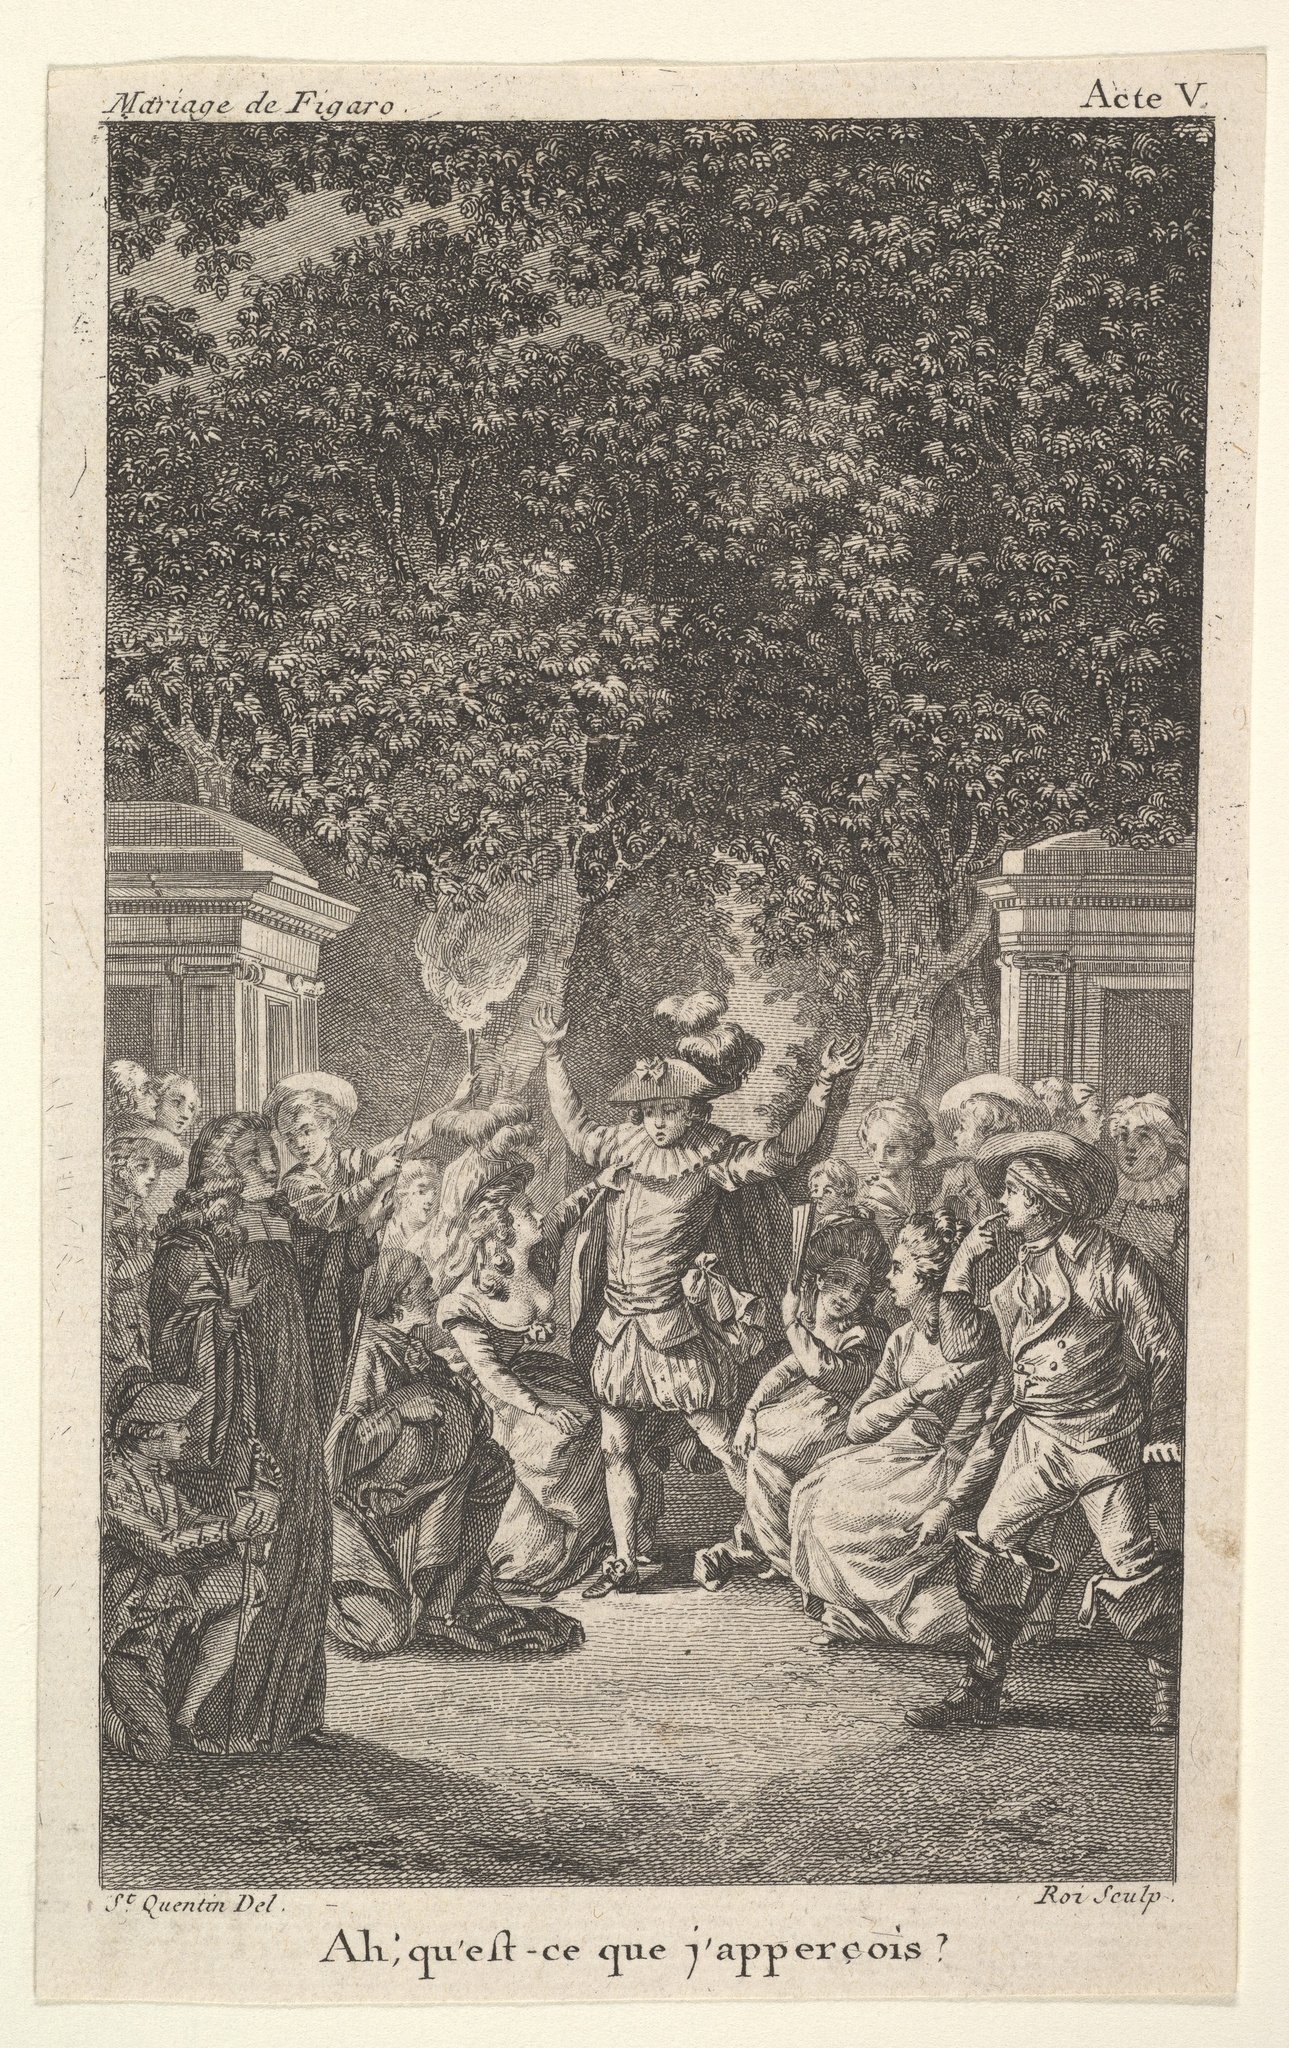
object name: print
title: A young boy holds a torch under trees in a garden, at center a man raises both arms, surrounded by male and female figures, from a series of five illustrations after Jacques Philippe Joseph de Saint-Quentin for 'The mad day, or the marriage of Figaro' (La Folle journée, ou le mariage de Figaro) by Pierre Augustin Caron de Beaumarchais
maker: jacques philippe joseph de saint quentin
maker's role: artist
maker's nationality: french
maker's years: 1738-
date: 1784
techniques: engraving, etching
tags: gardens,boys,men,women